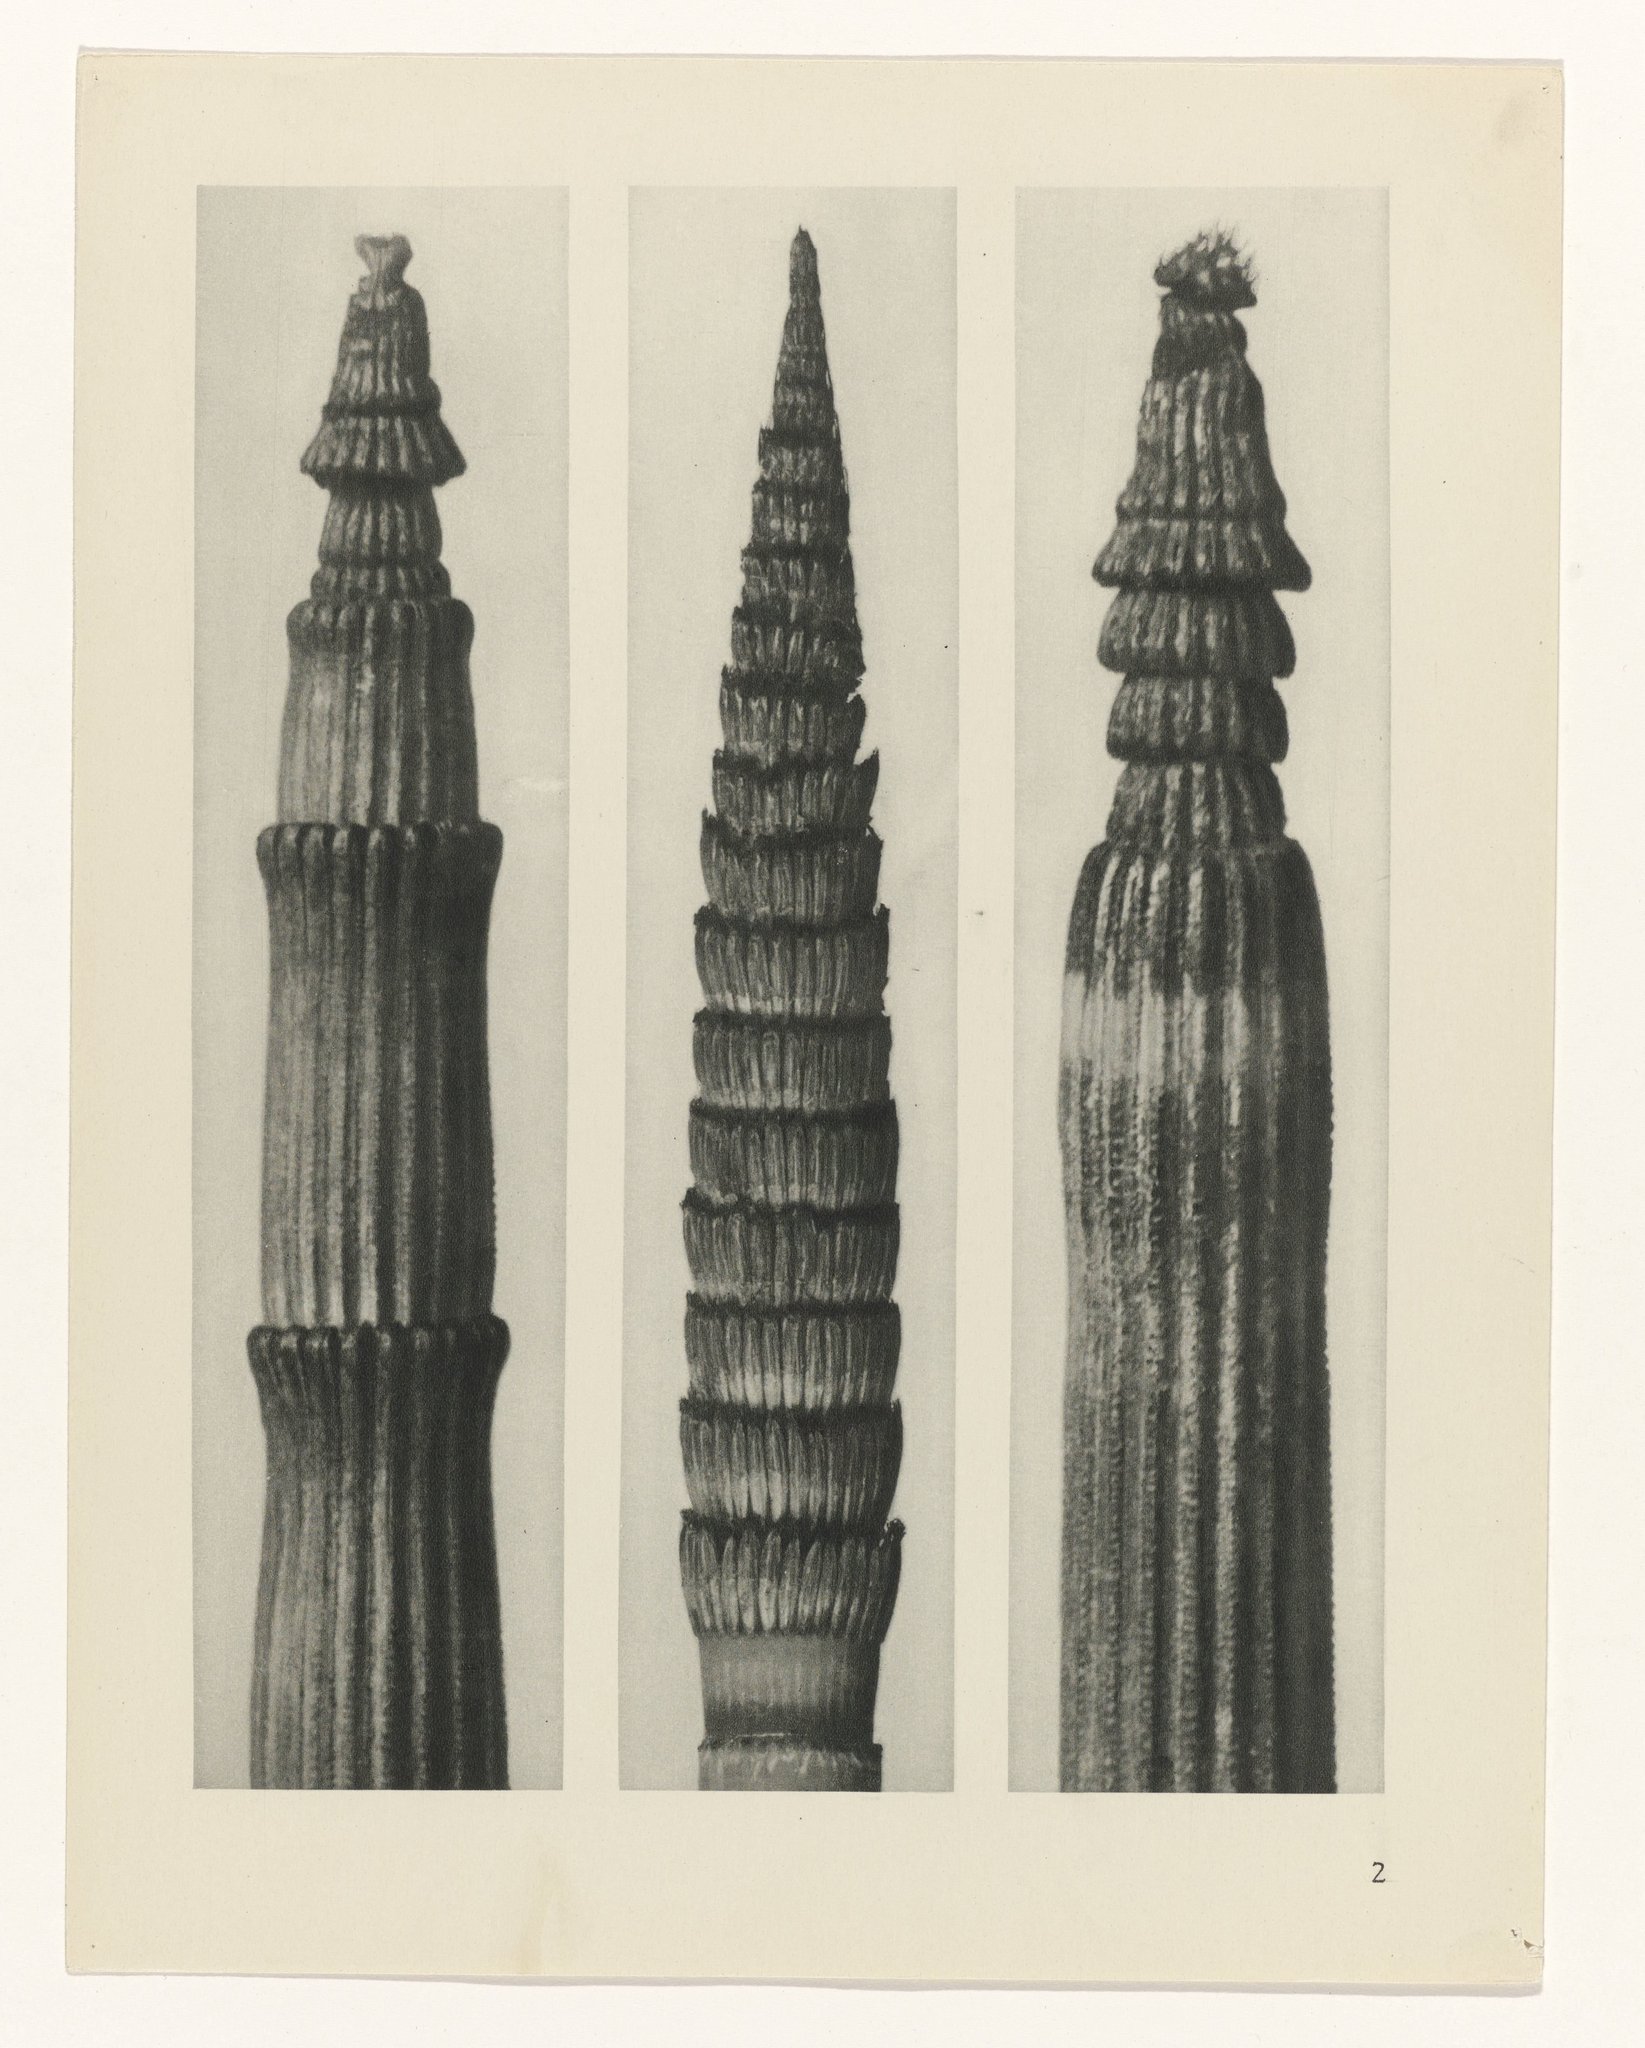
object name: photograph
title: Plantstudie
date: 1928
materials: ink, paper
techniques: rotogravure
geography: berlin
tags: plants (in general)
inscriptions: number: ‘2’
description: facher Vergrößerung. Afkomstig uit losbladige uitgave.